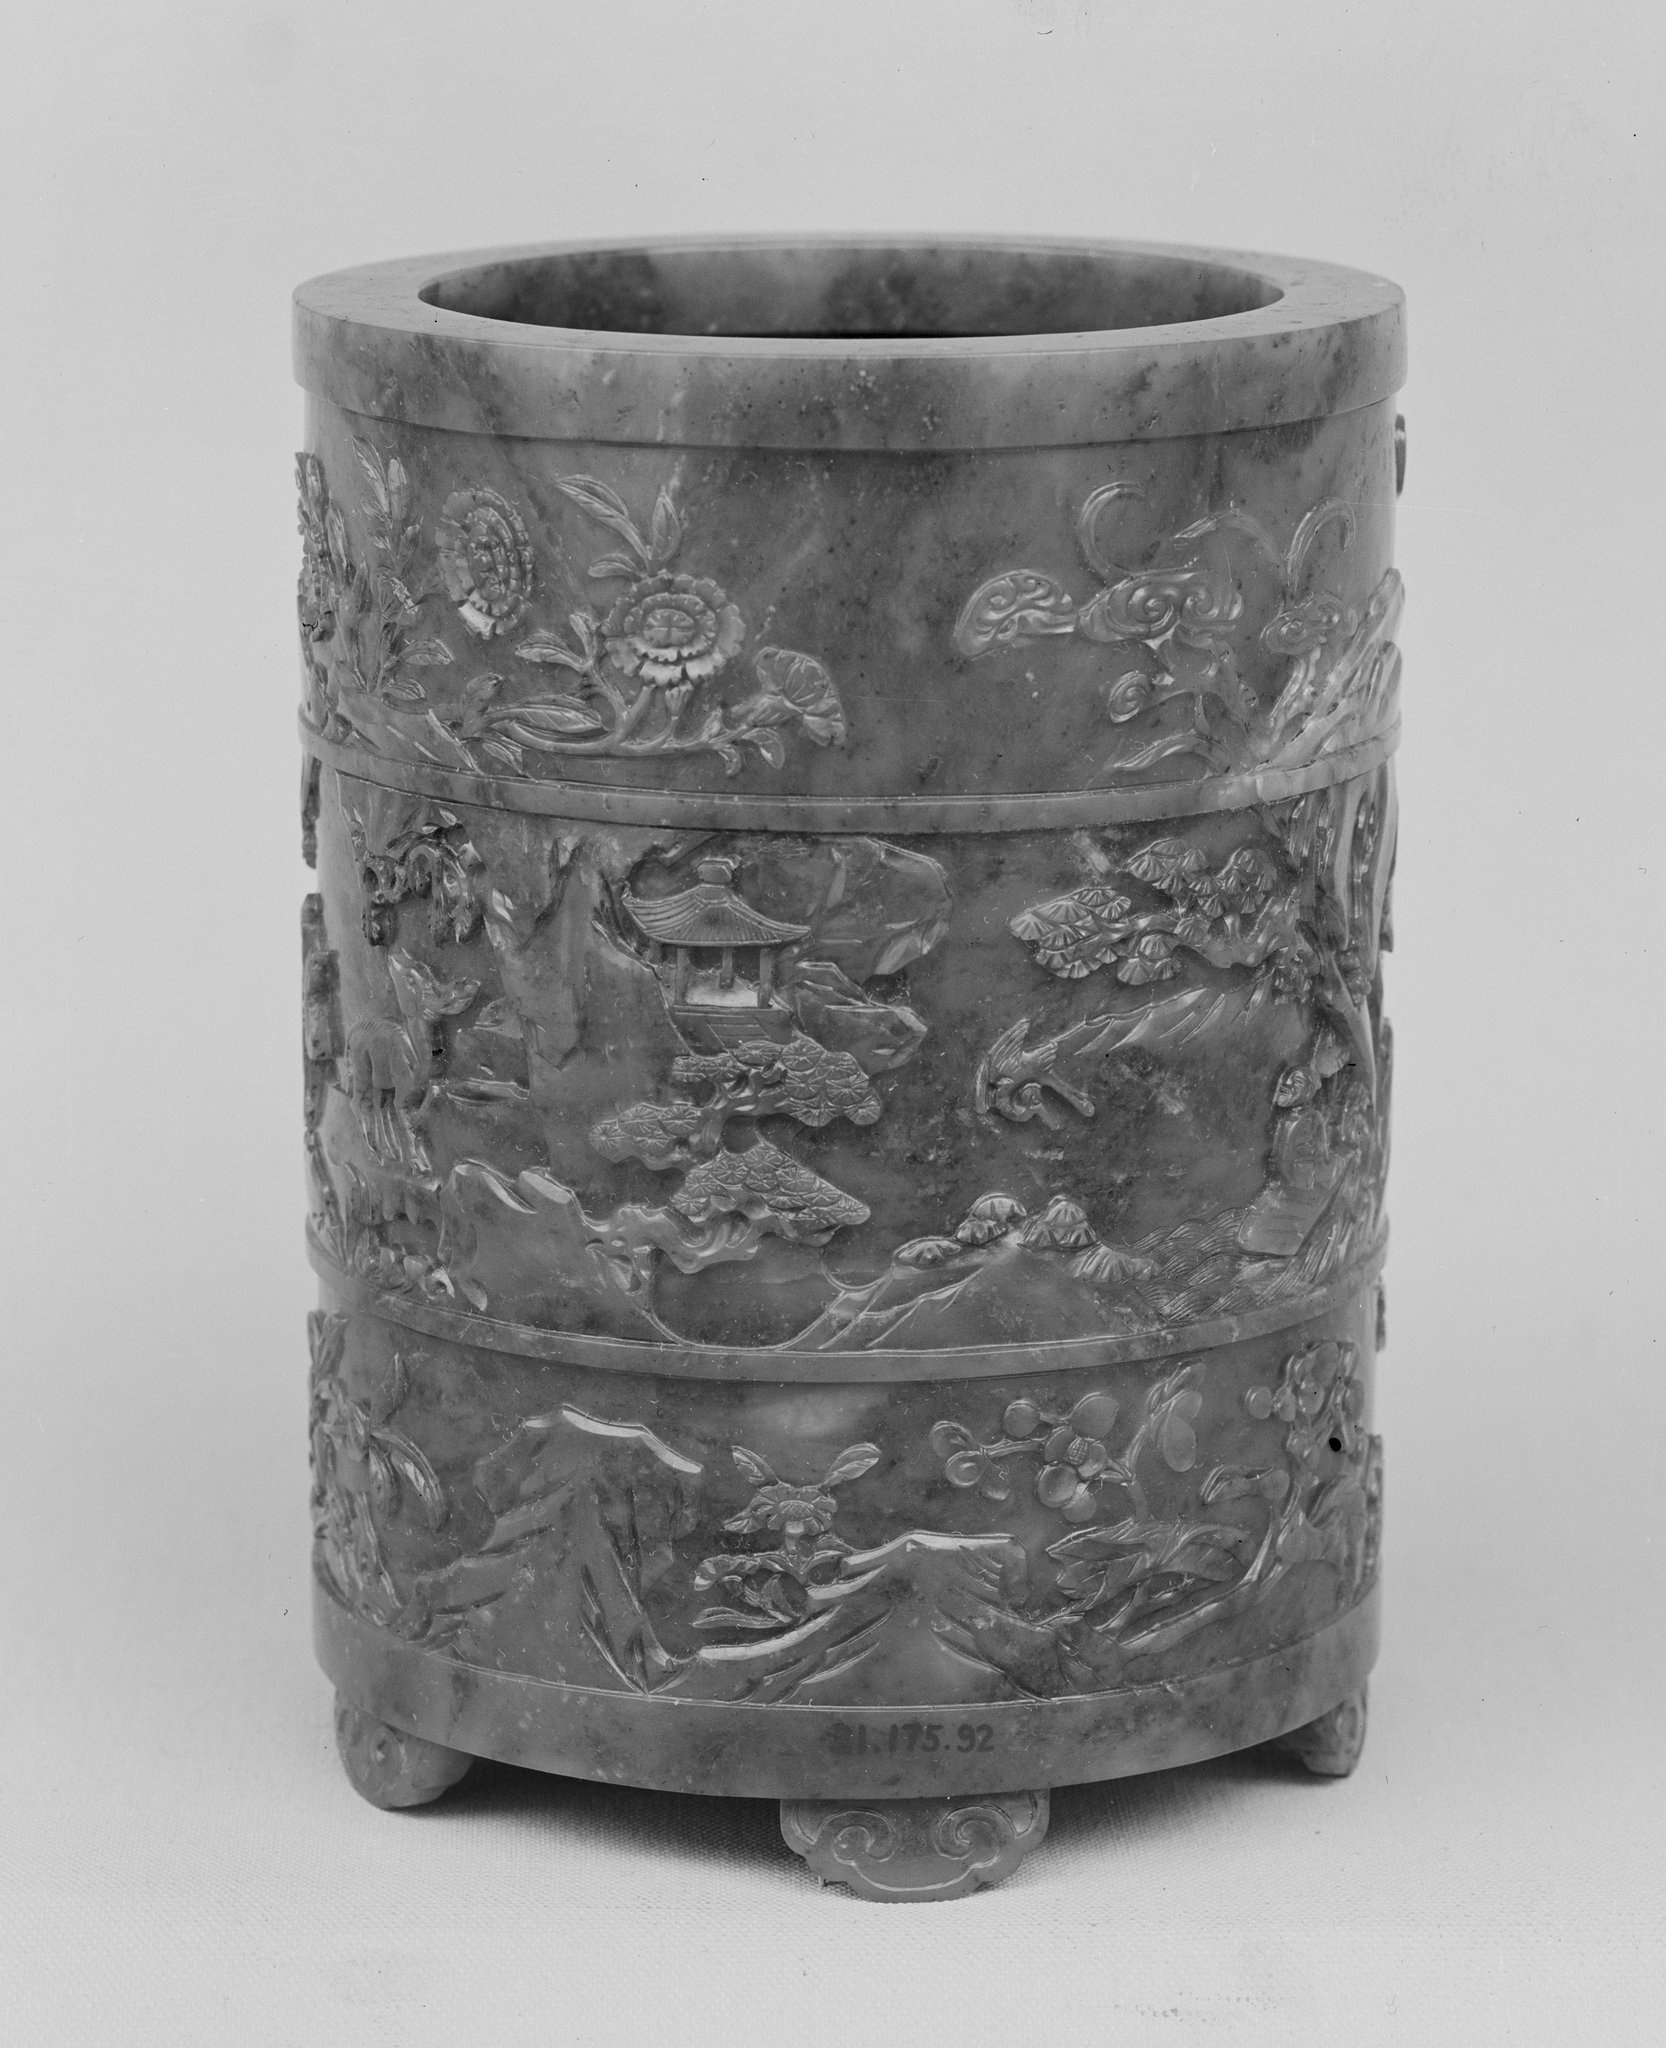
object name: brush holder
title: Brush holder with immortal realms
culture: chinese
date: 1767-1800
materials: jade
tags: flowers